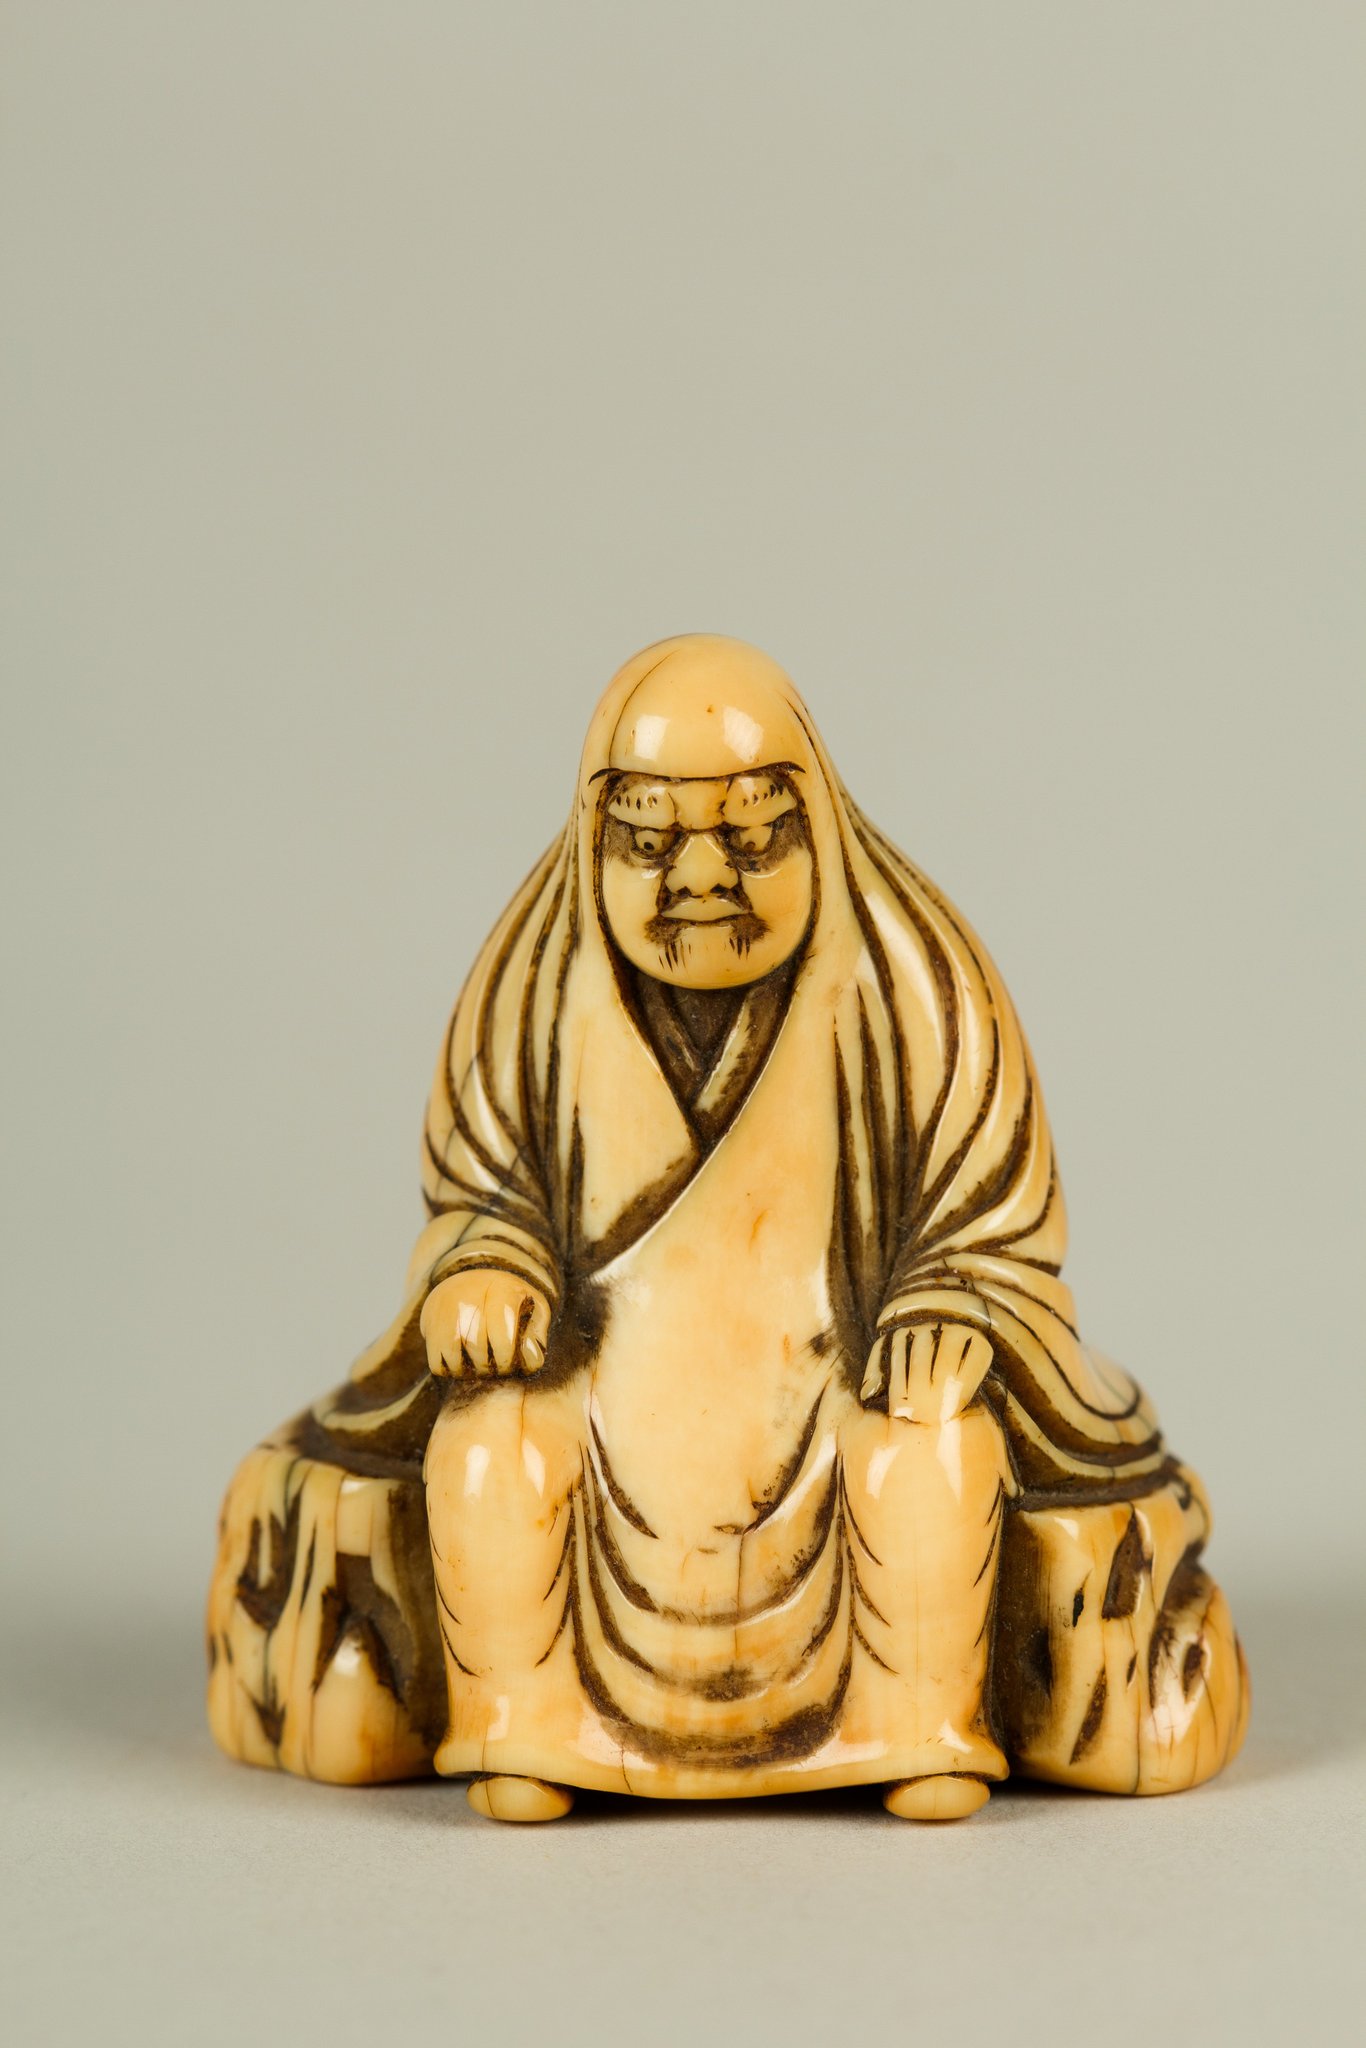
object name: netsuke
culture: japanese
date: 1801-1900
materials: ivory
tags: men